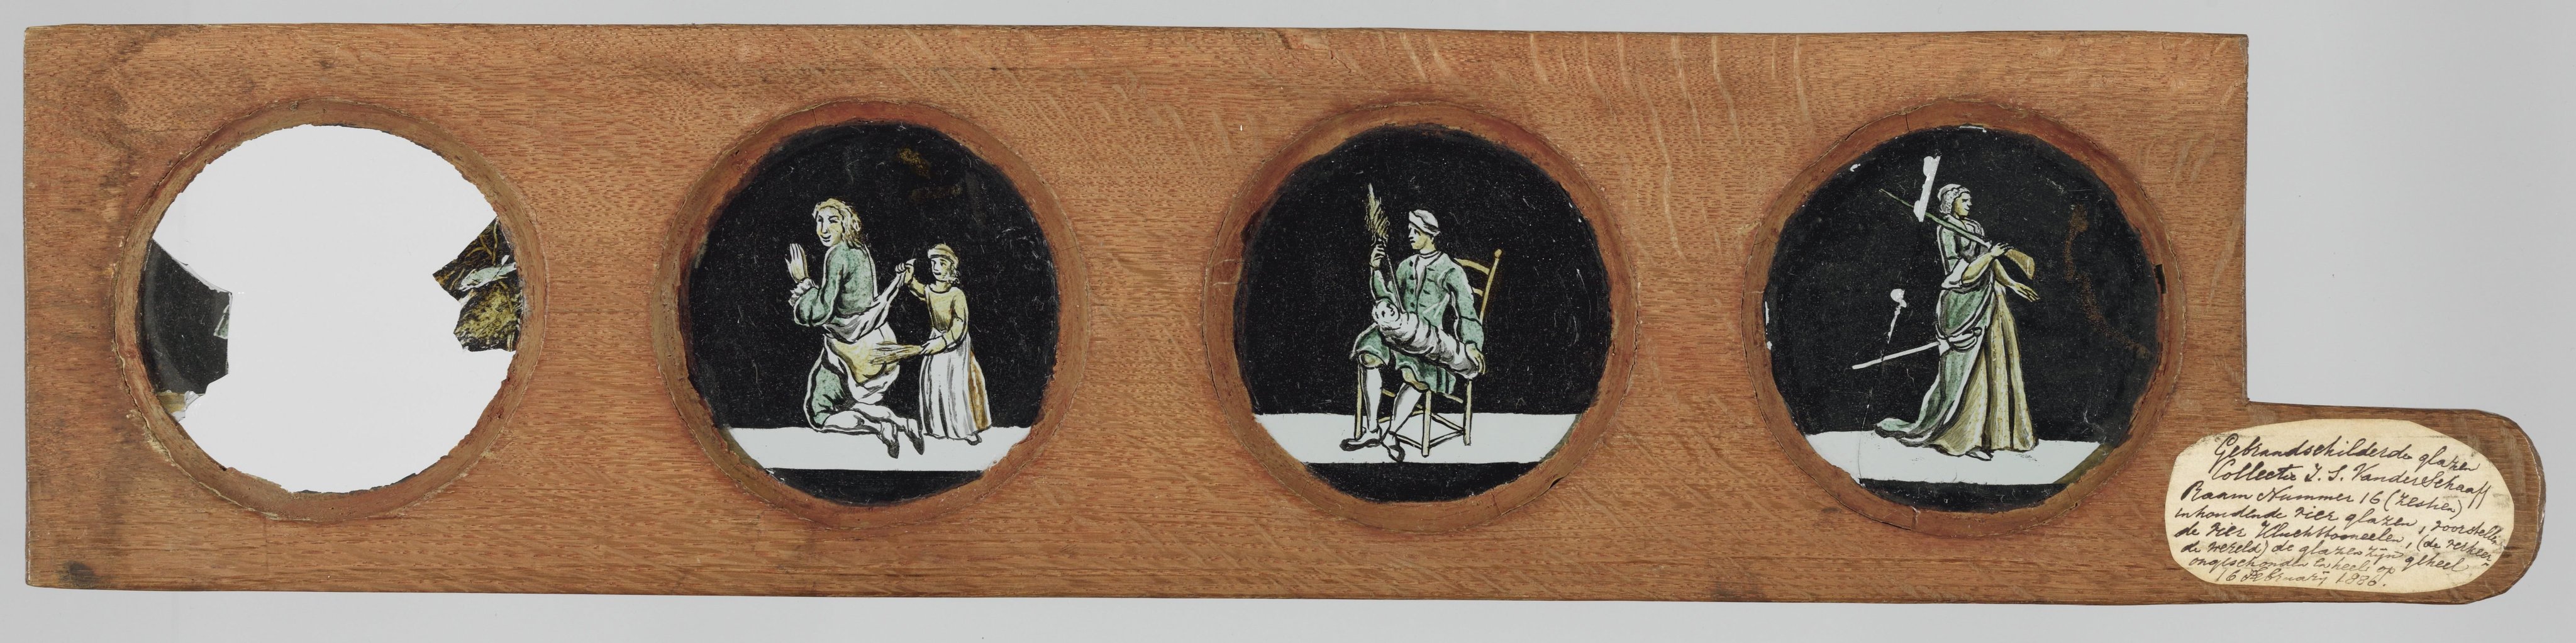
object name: lantern slide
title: Drie kluchtspelers op drie verschillende glasplaten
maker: Anonymous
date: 1700-1790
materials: glass, wood, oil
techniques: painted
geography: netherlands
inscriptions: label: ‘'Gebrandschilderde glazen. Collectie I.S. van der Schaaff, Baarn. Nummer 16 (zestien) inhoudende vier glazen, voorstellende vier kluchtspelers. Alle glazen zijn geheel ongeschonden en heel op 16 februarij 1886.'’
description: Drie ronde glazen in een houten vatting met handvat. Een vierde glaasje ontbreekt.Uiterst links:ontbreekt. Rechts daarvan: een kind geeft een volwassen man een pak slaag met een roe. Rechts daarvan: een man zit in een stoel met op zijn schoot een ingezwachtelde baby en in zijn rechterhand een spinklos. Uiterst rechts: een vrouw loopt met een sabel aangegord en een geweer over haar schouder.